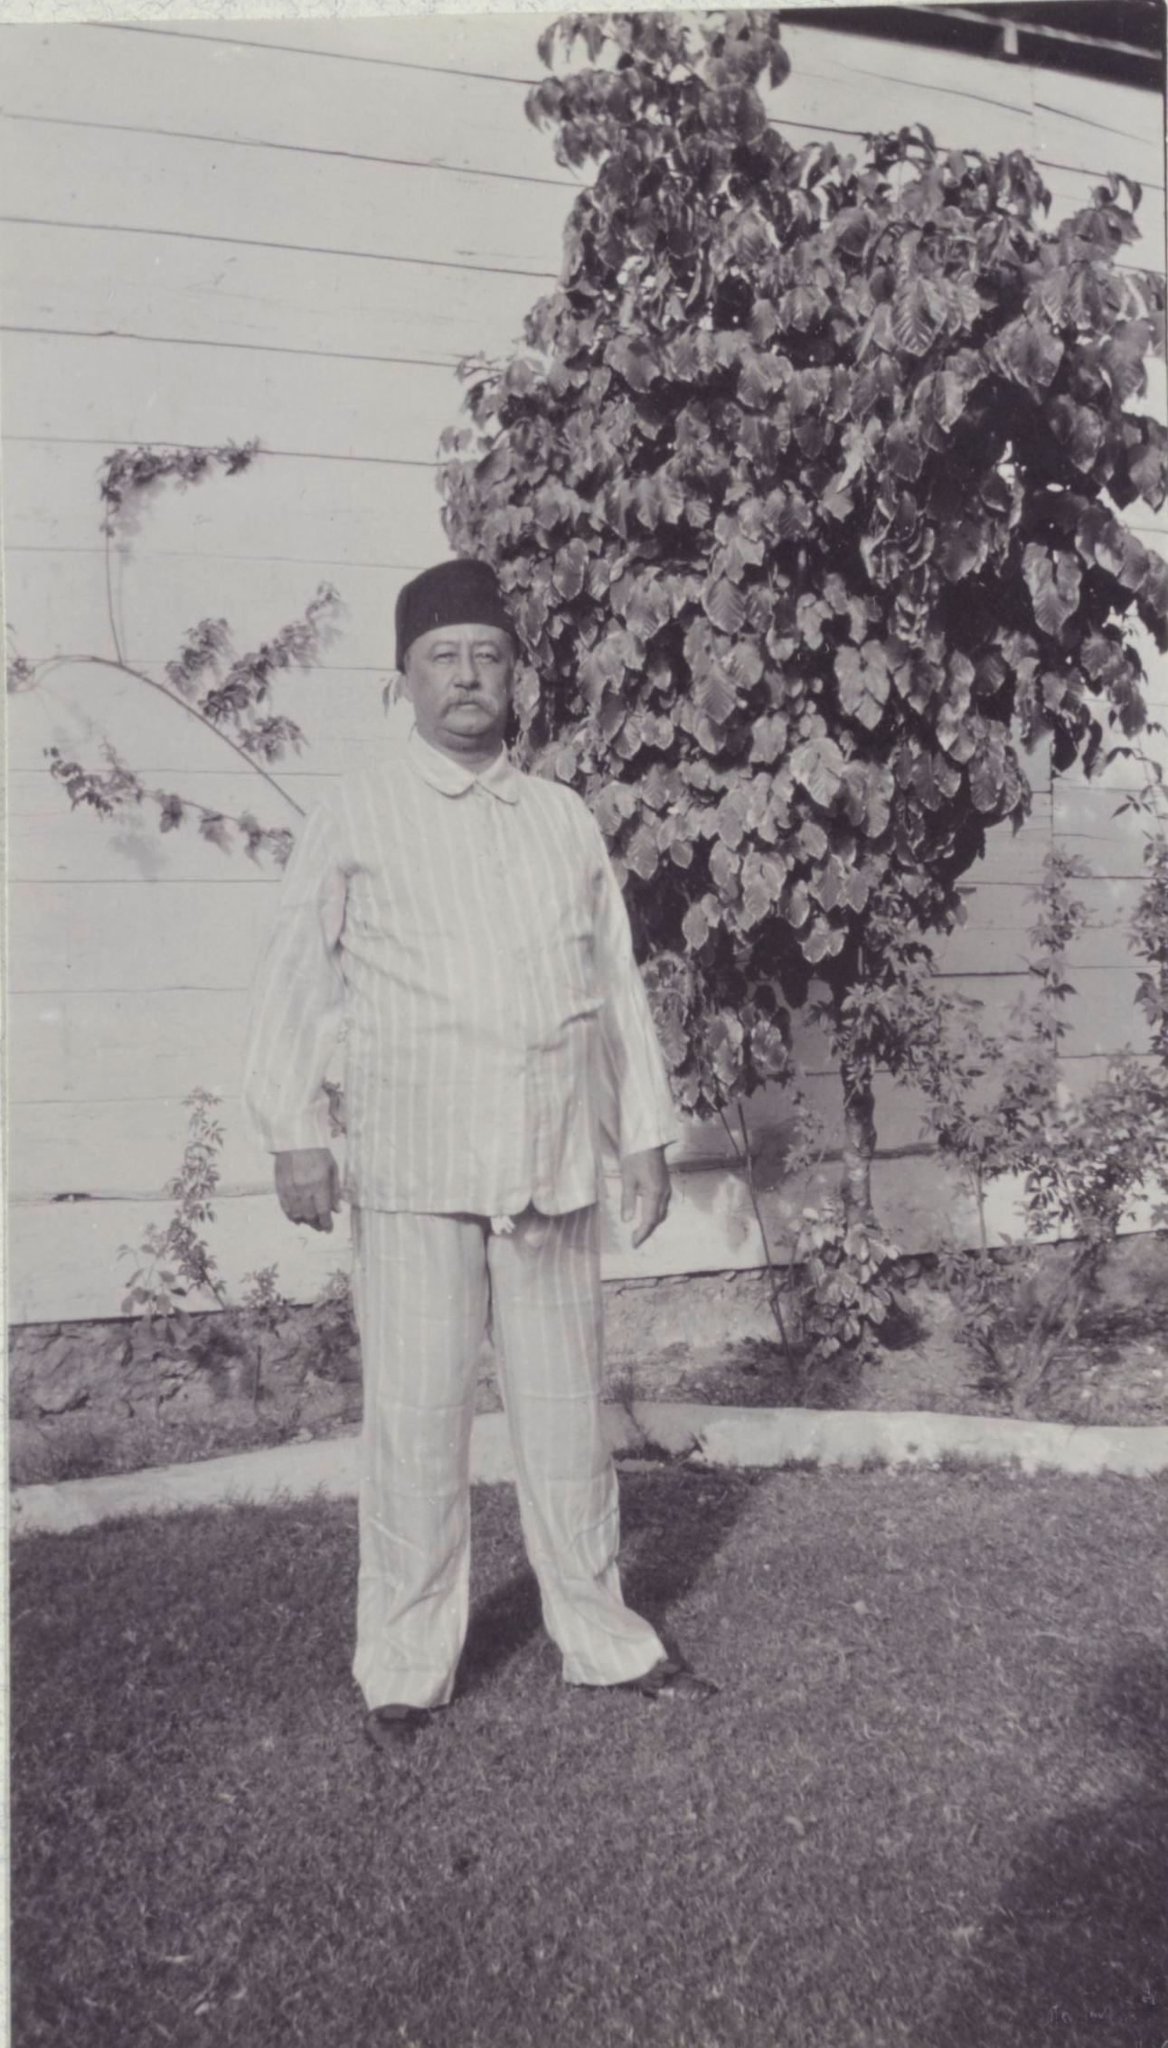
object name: photograph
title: Mr. Lyon Hall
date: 1901-1912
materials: photographic support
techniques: photography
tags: port-au-prince, haïti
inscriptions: inscription: ‘Mr. Lyon Hall. / P. au P. Jan. 1912’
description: Portret van Mr. Lyon Hall, gekleed in een pyjama, staande in de tuin van zijn huis in Port-au-Prince op Haïti, januari 1912. Onderdeel van het fotoalbum van de familie Boom-Gonggrijp in Suriname en Curaçao.